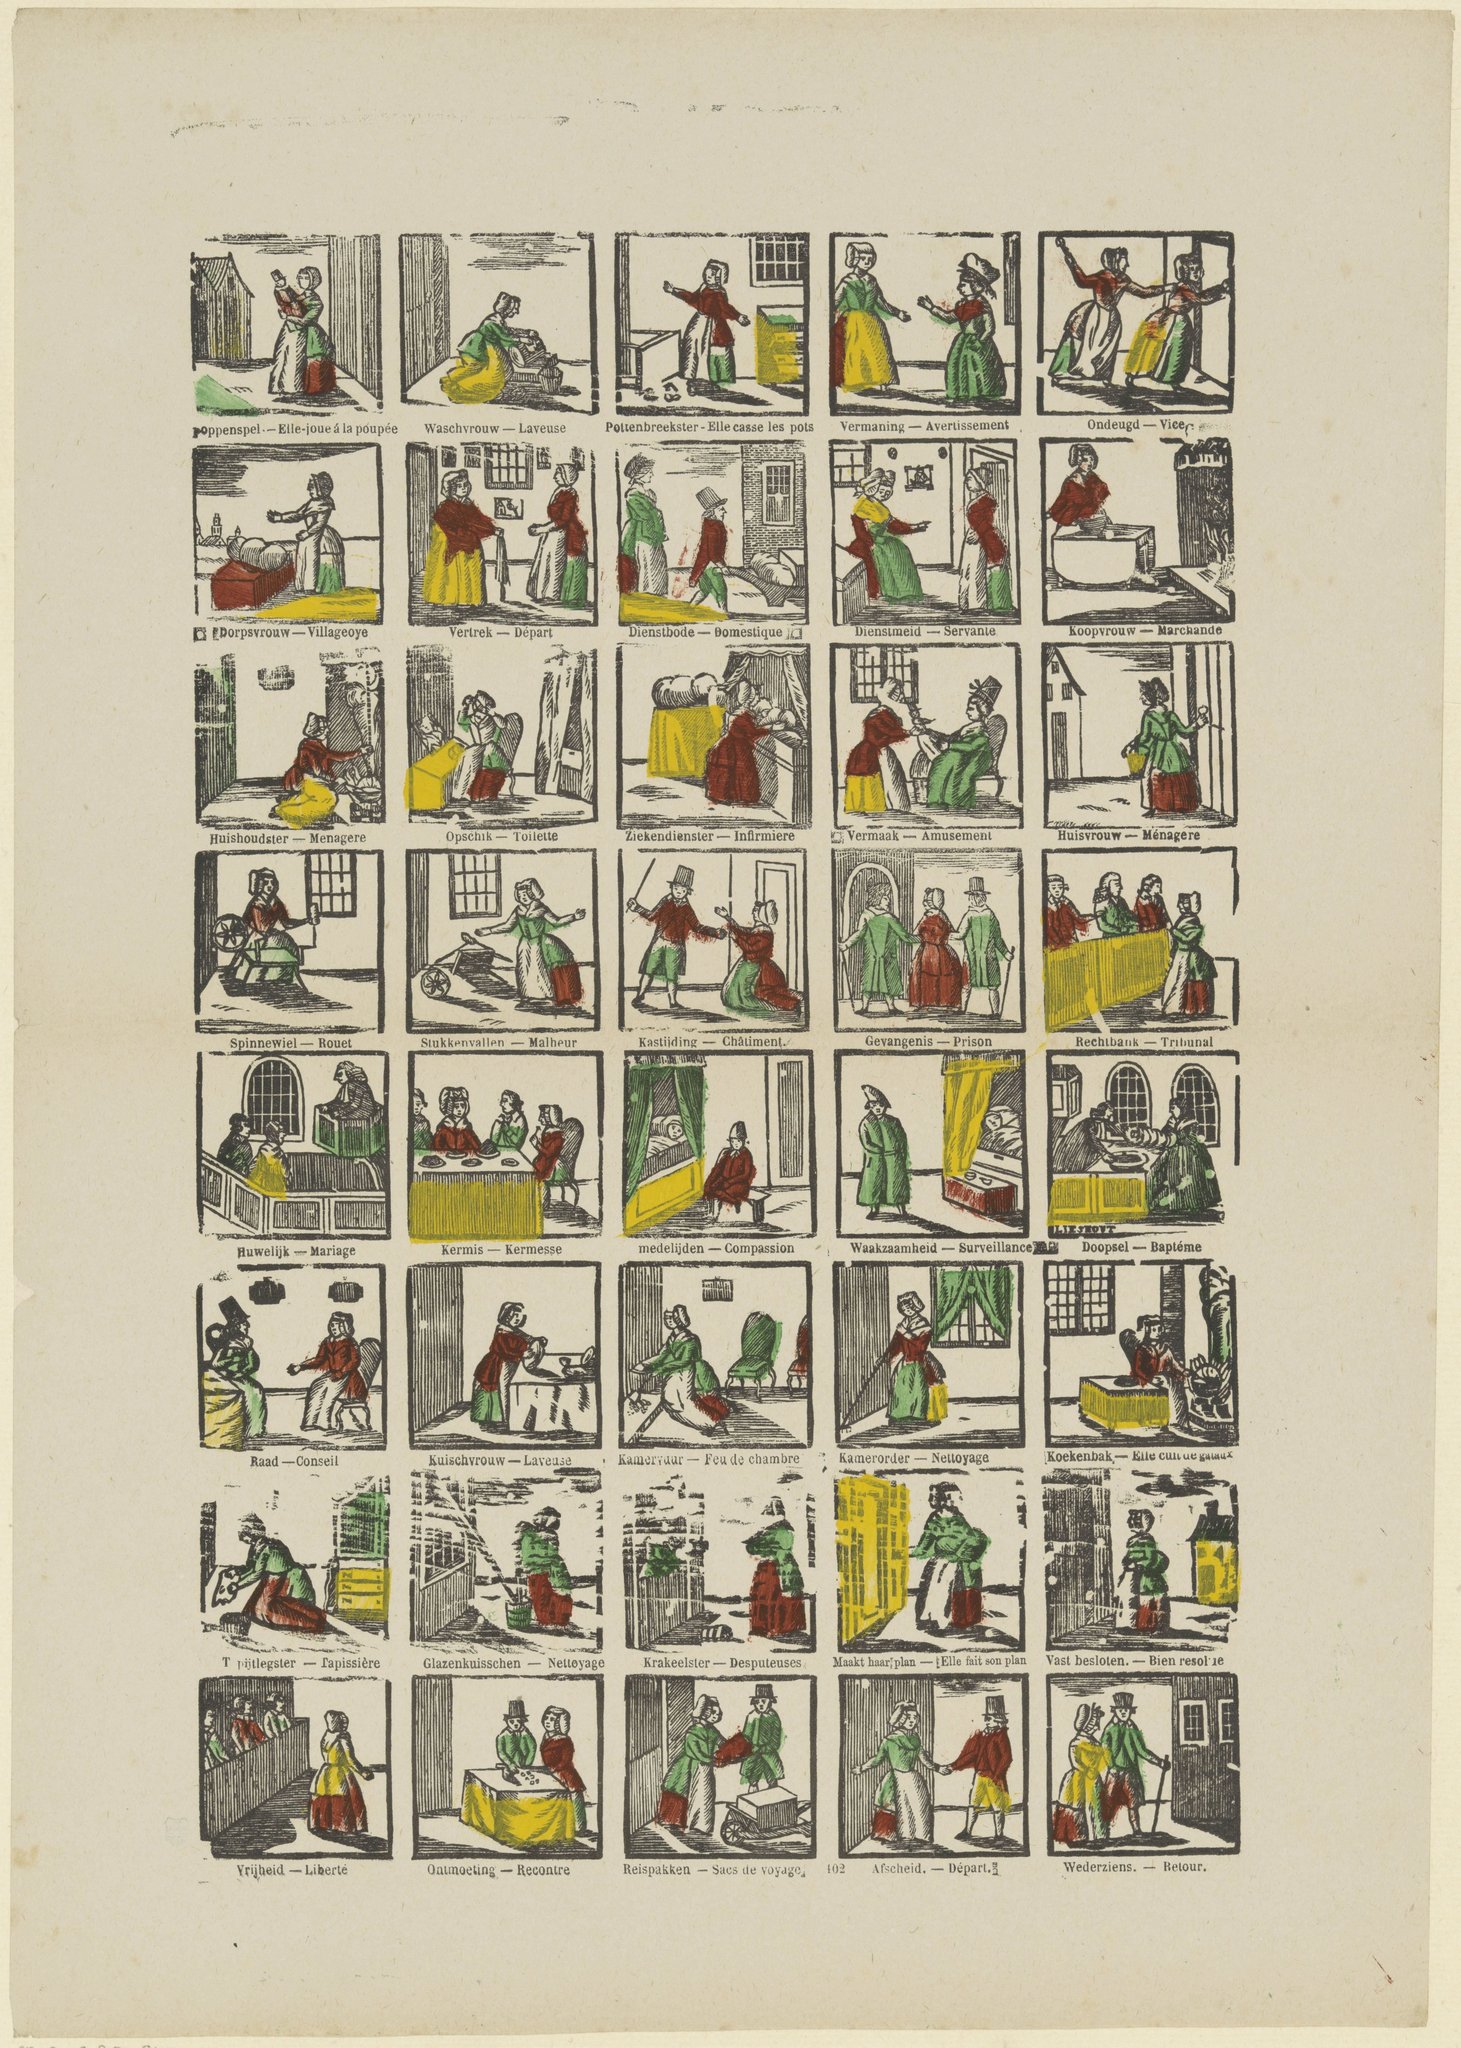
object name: popular print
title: Verschillende voorstellingen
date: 1866-1902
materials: paper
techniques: colour, letterpress printing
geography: europe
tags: civil marriage ceremony, maid ~ house personnel, baptism, christening ceremony ~ the first of the seven sacraments - qq - baptism in the open air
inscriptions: collector's mark: Lugt 2760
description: Blad met 40 voorstellingen van dienstmeisjes aan het werk, een huwelijk, een doopsel en een man en vrouw die afscheid nemen. Onder elke afbeelding een onderschrift in het Nederlands en in het Frans. Genummerd midden onder: 102.